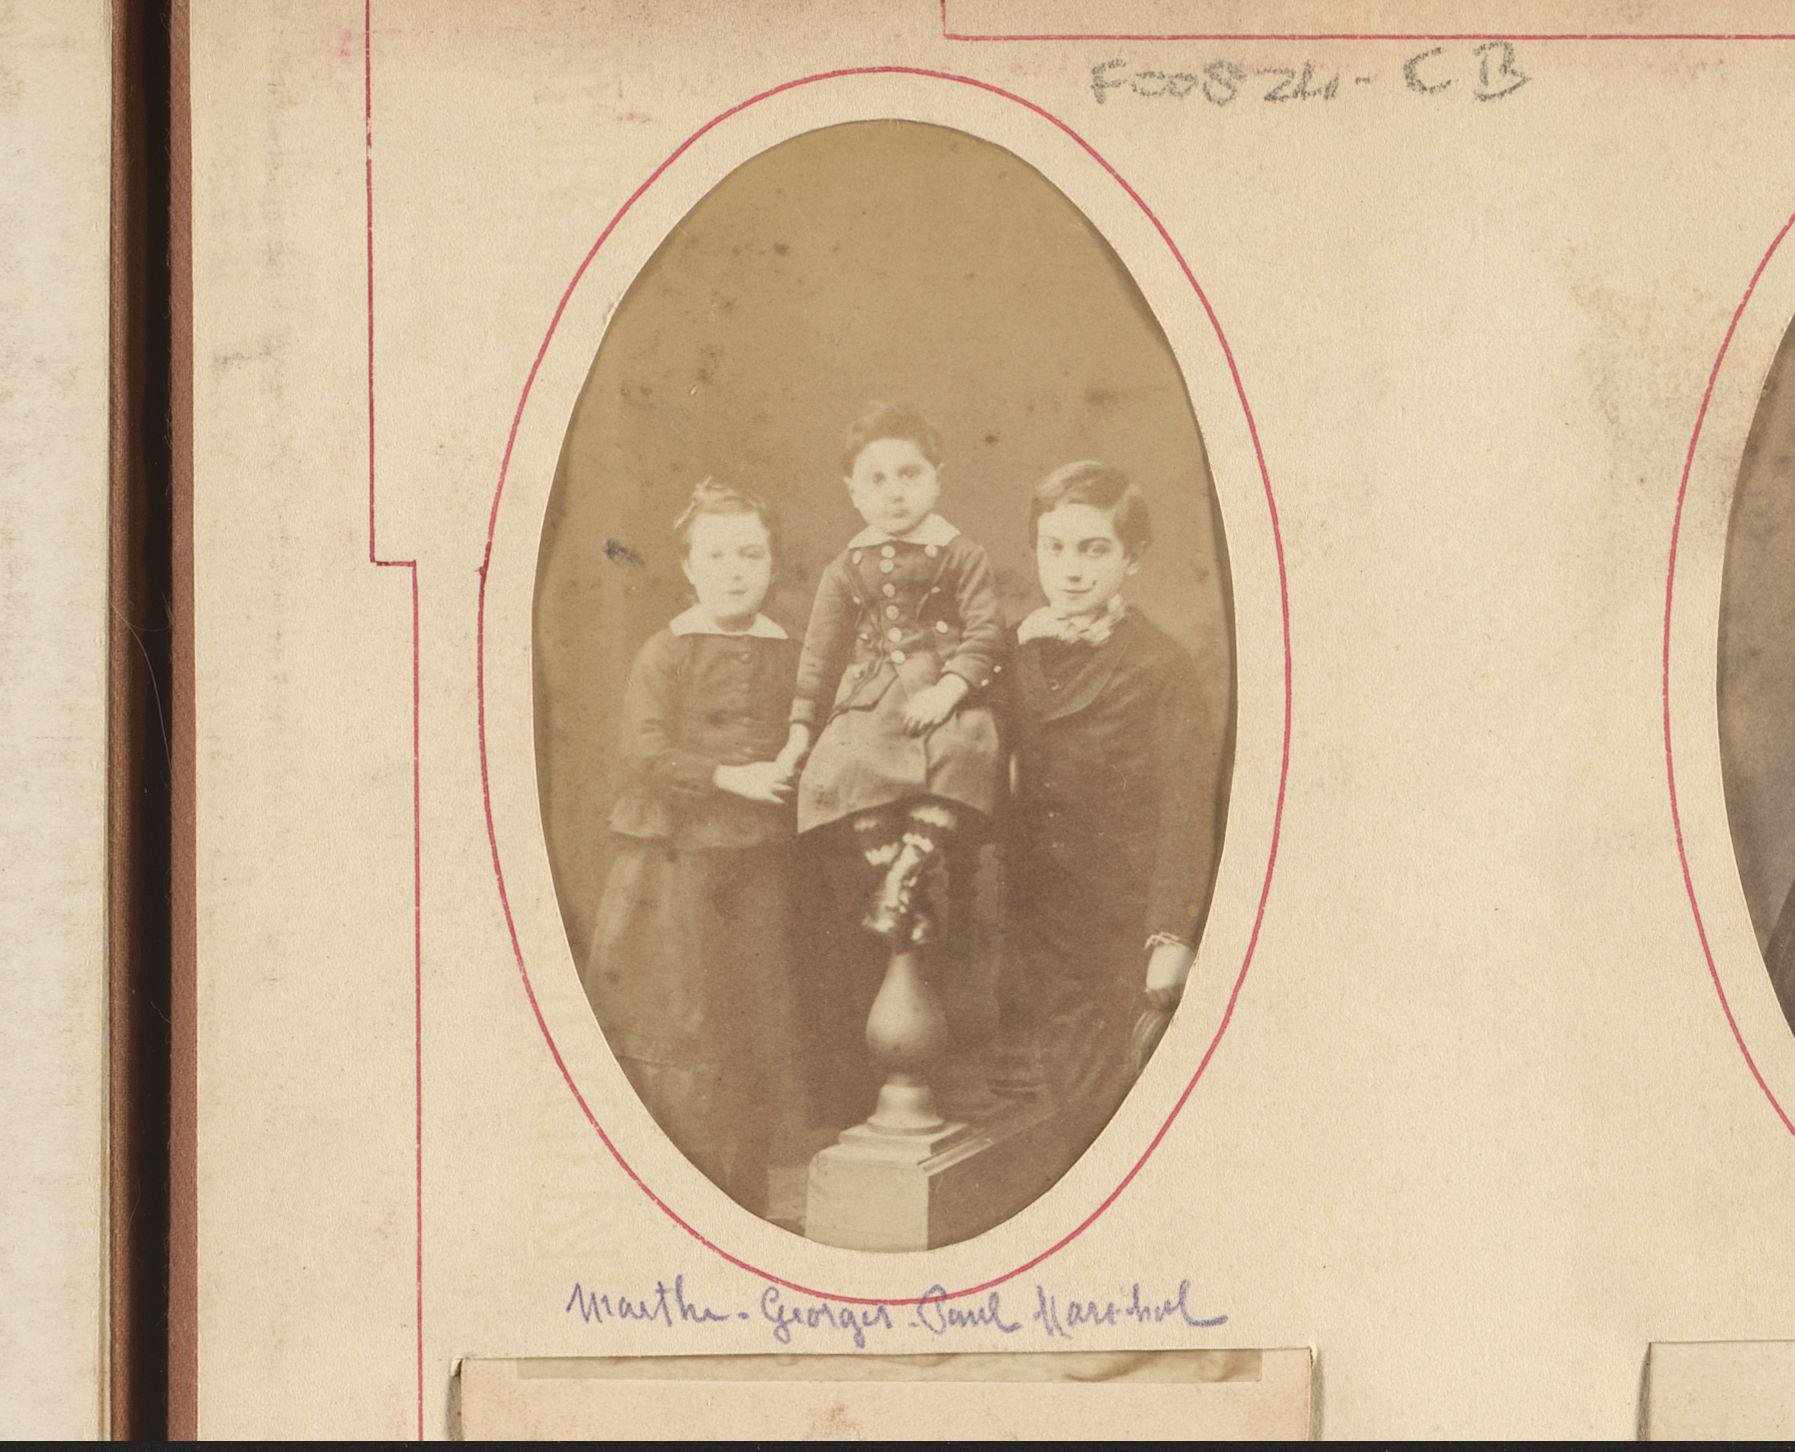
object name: photograph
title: Groepsportret van Marthe, Georges en Paul Maréchal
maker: de l oratoire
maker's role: fotograaf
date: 1854-1885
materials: cardboard, paper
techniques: albumen print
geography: paris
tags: boy (child between toddler and youth), girl (child between toddler and youth), anonymous historical persons portrayed in a group, in a group-portrait, paris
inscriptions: address: ‘152, Rue St-Honoré, 152/ PARIS’